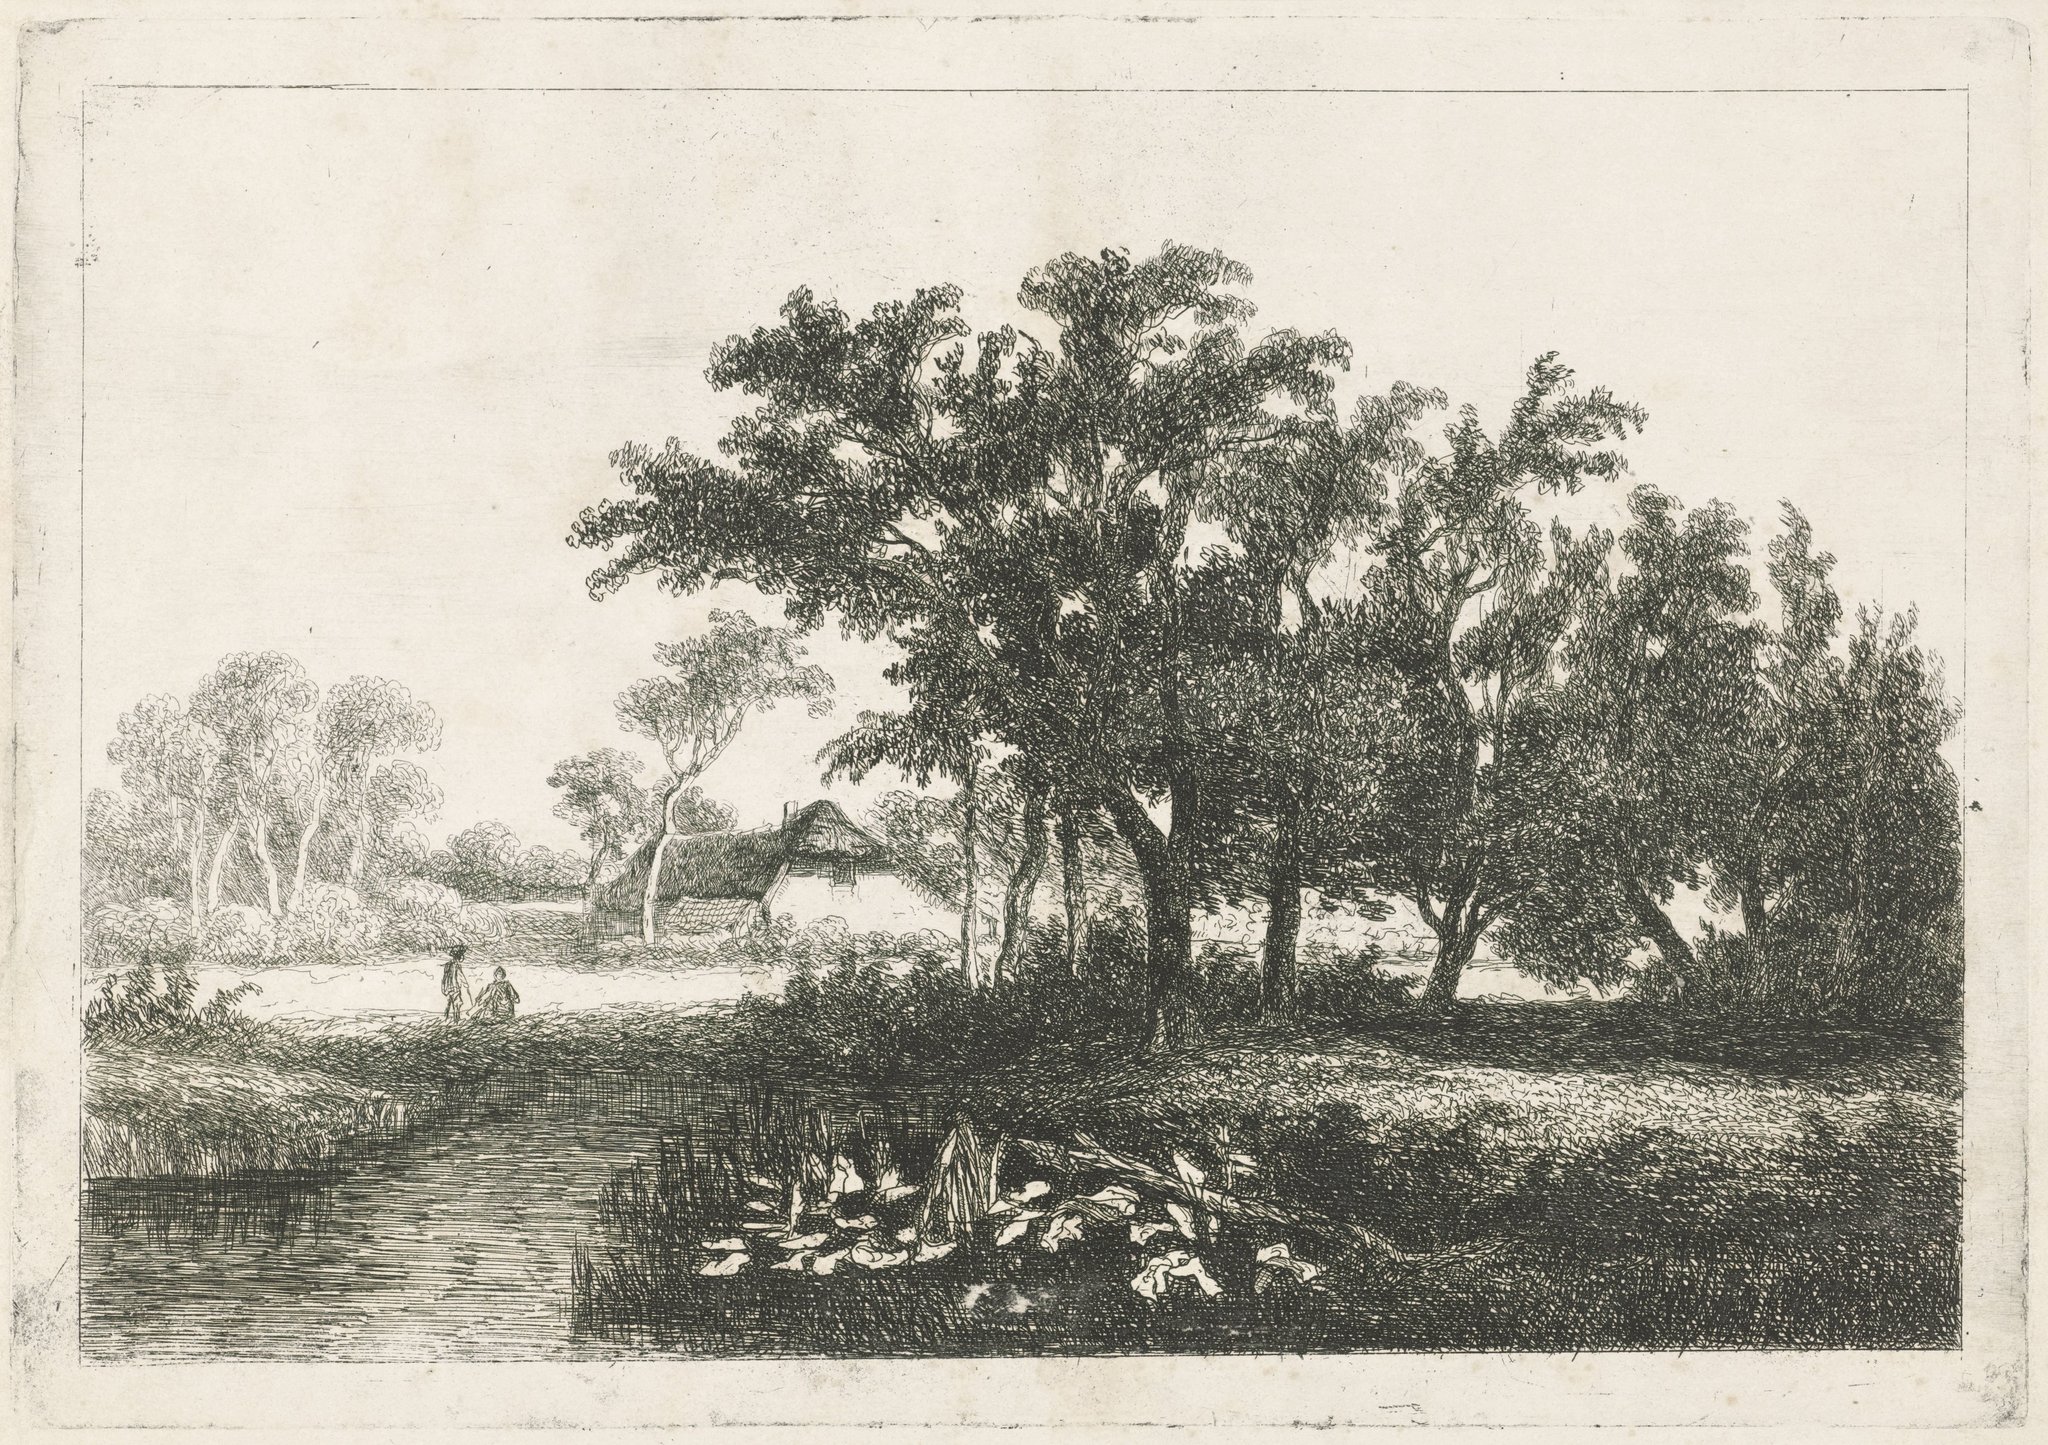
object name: print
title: Twee figuren bij een smalle rivier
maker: hermanus jan hendrik van rijkelijkhuysen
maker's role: painter, print maker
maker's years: 1813-1883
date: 1823-1883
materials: paper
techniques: drypoint, etching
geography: utrecht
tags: trees, river, farm or solitary house in landscape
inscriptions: collector's mark: Lugt 2228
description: Gezicht over een riviertje op een landschap met aan de waterkant twee figuren. Naast het water enige bomen en op de achtergrond een boerenhoeve.